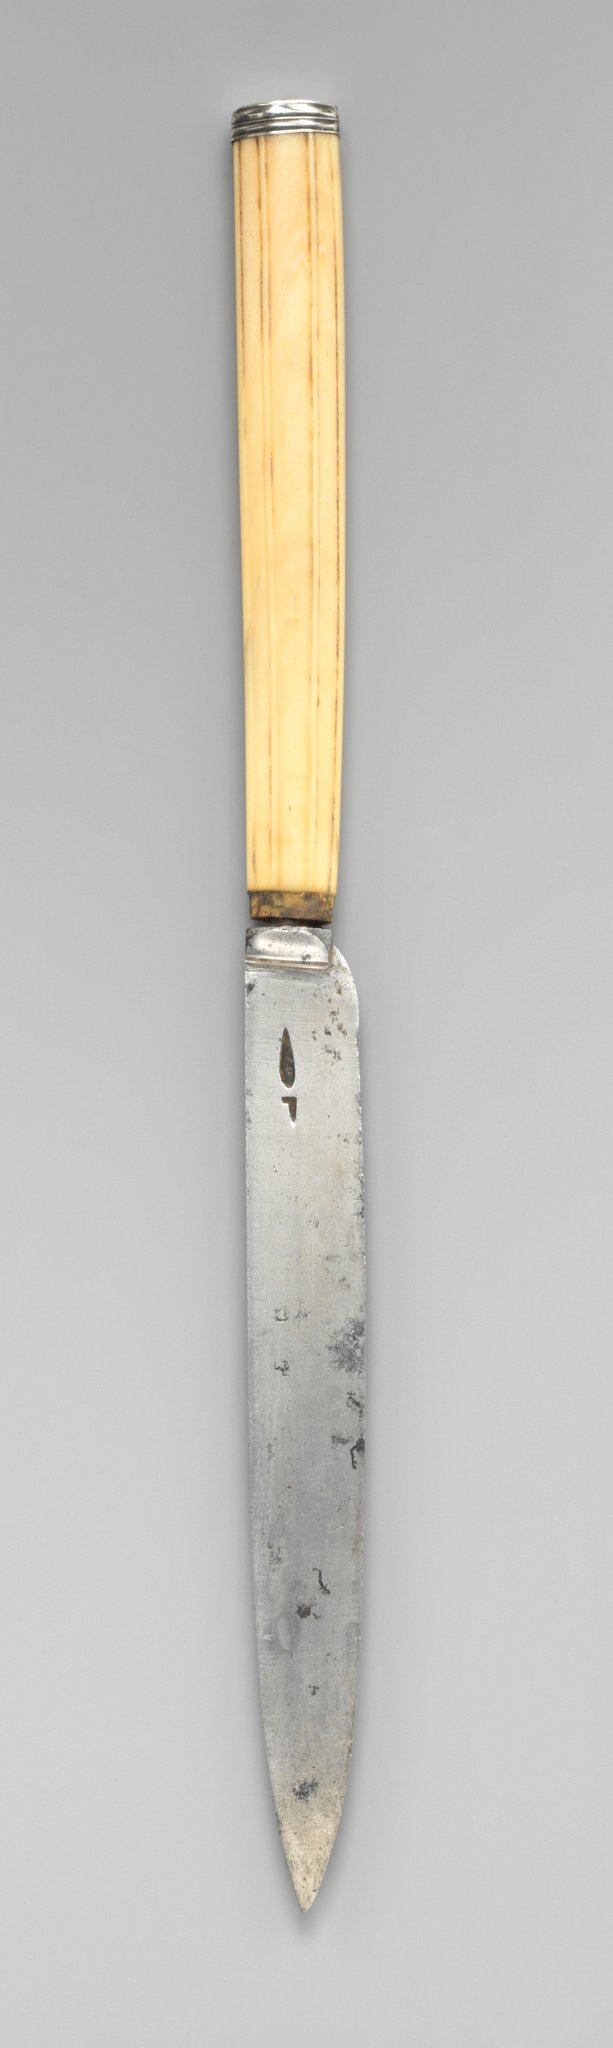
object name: table knife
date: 1801-1900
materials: ivory, steel